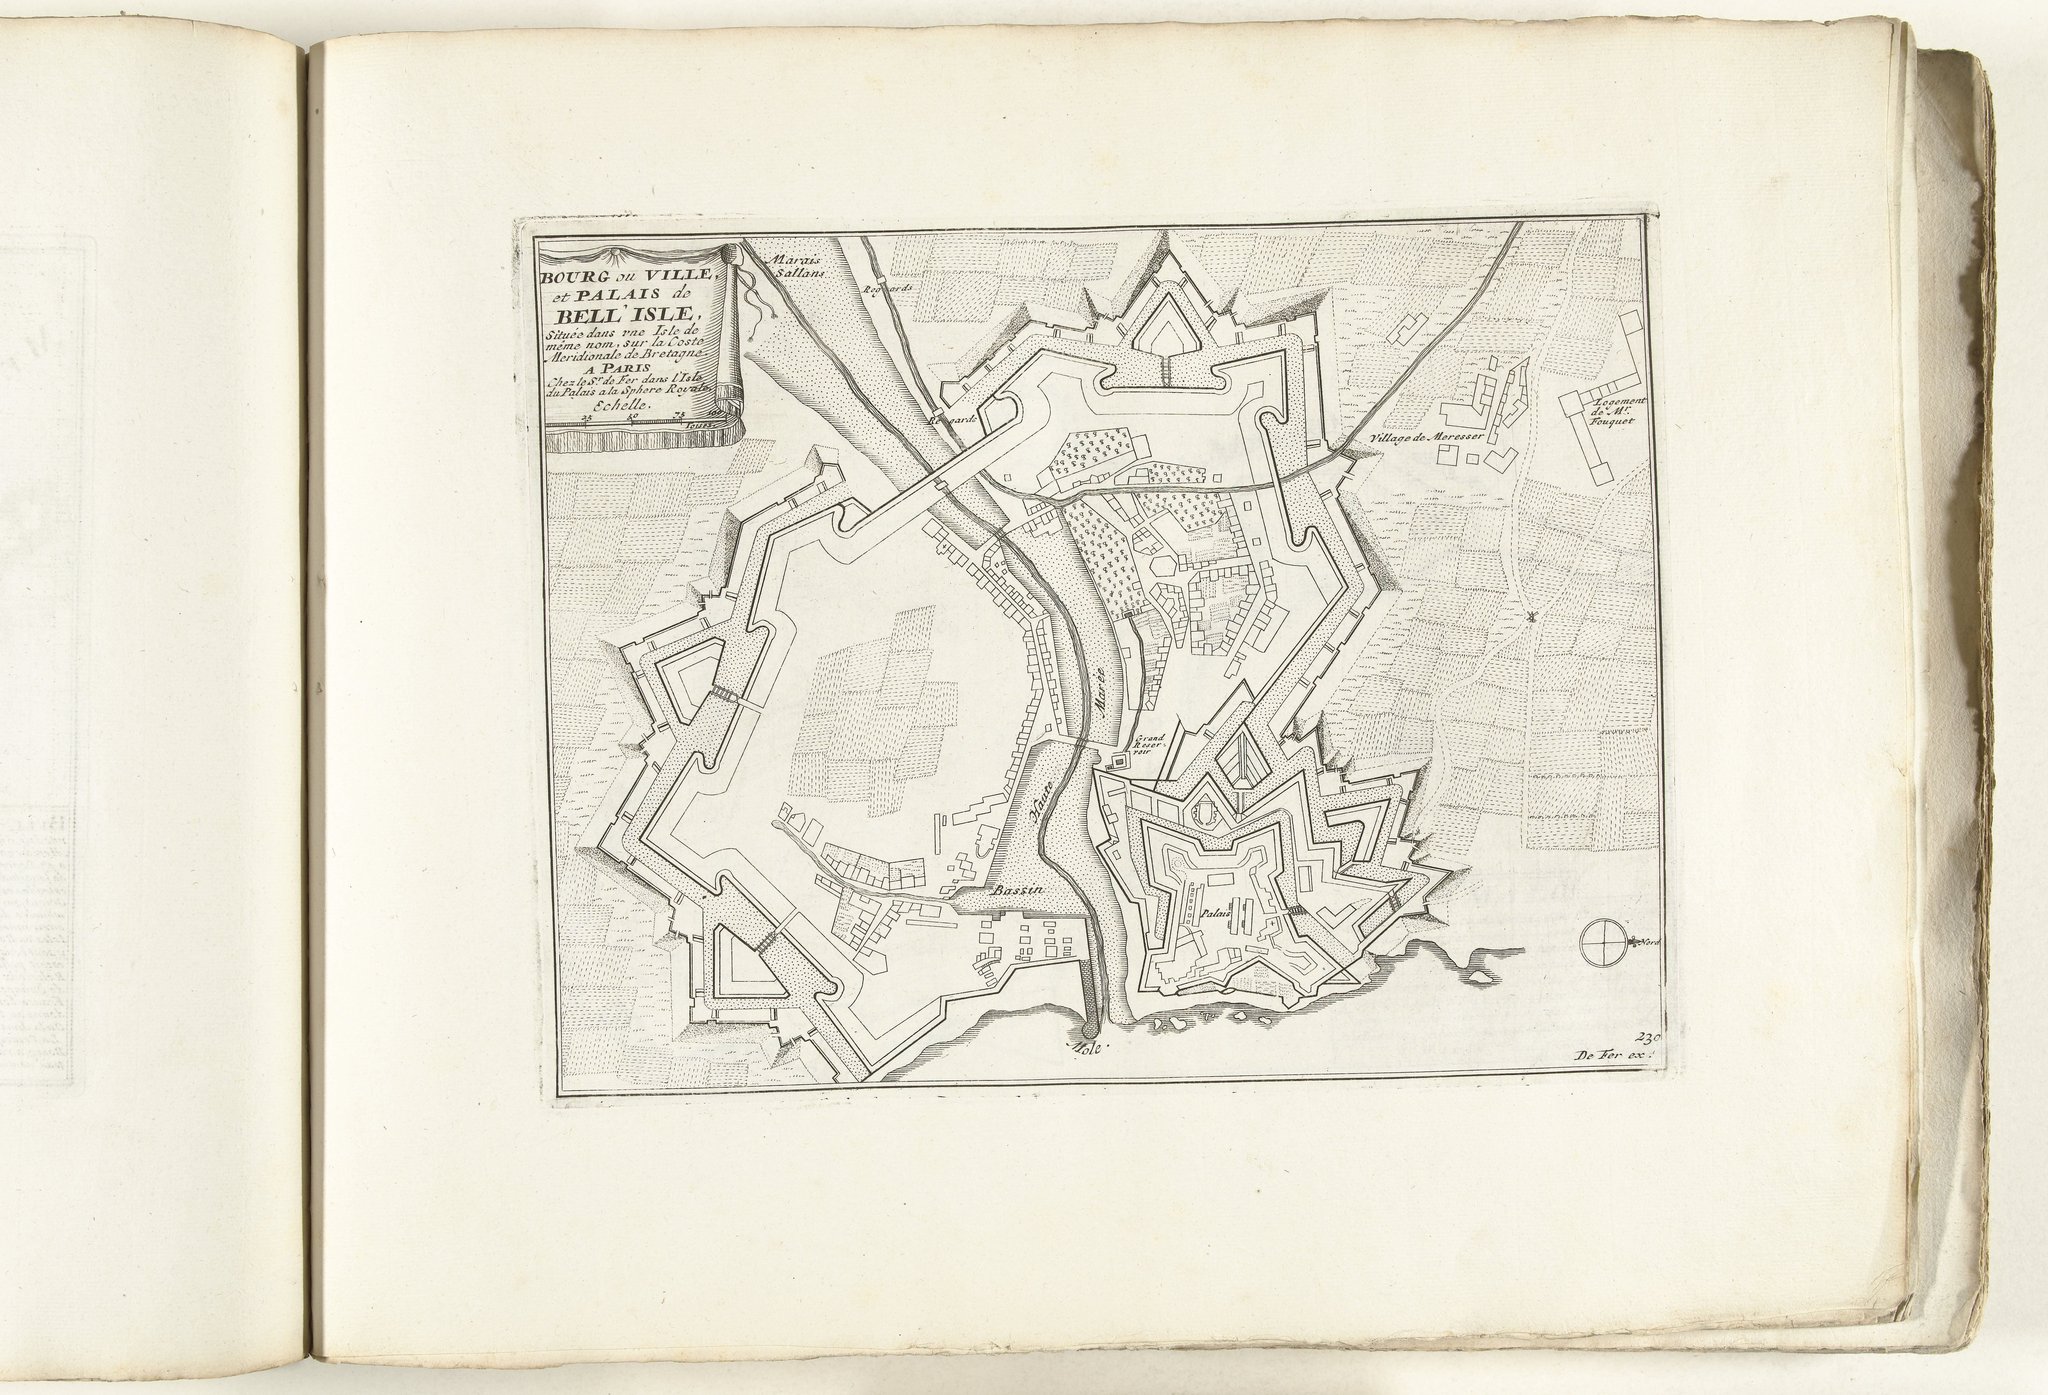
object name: print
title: Plattegrond van Belle Ile, ca. 1702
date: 1702-1703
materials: paper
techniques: etching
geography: paris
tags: fortress, maps of cities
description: Plattegrond van de versterkingen om de Franse stad en paleis van Belle Ile. Plaat nr. 230 in het prentwerk bestaande in totaal uit 276 genummerde platen van vermaarde sterke steden en vestingen in het kader van de Spaanse Successieoorlog. Voor het merendeel zijn deze platen gekopieerd naar de anonieme Franse platen: in Les forces de l'Europe en in: Le theatre de la guerre, dans les Pays-Bas, beide oorspronkelijk uitgegeven door Nicolas de Fer te Parijs (1693-1697) in het kader van de Negenjarige Oorlog. Titel en opschriften in de plaat in het Frans.